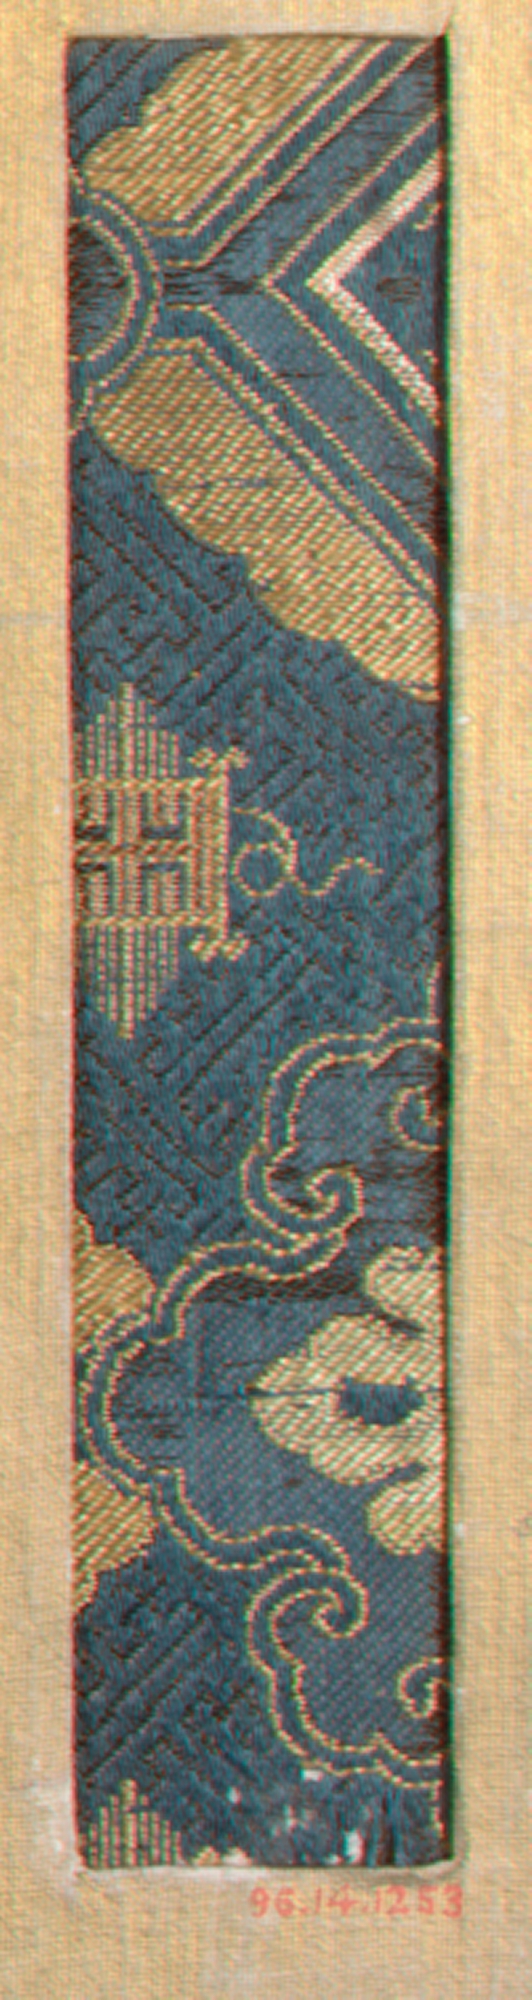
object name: piece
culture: japanese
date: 1701-1900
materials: silk